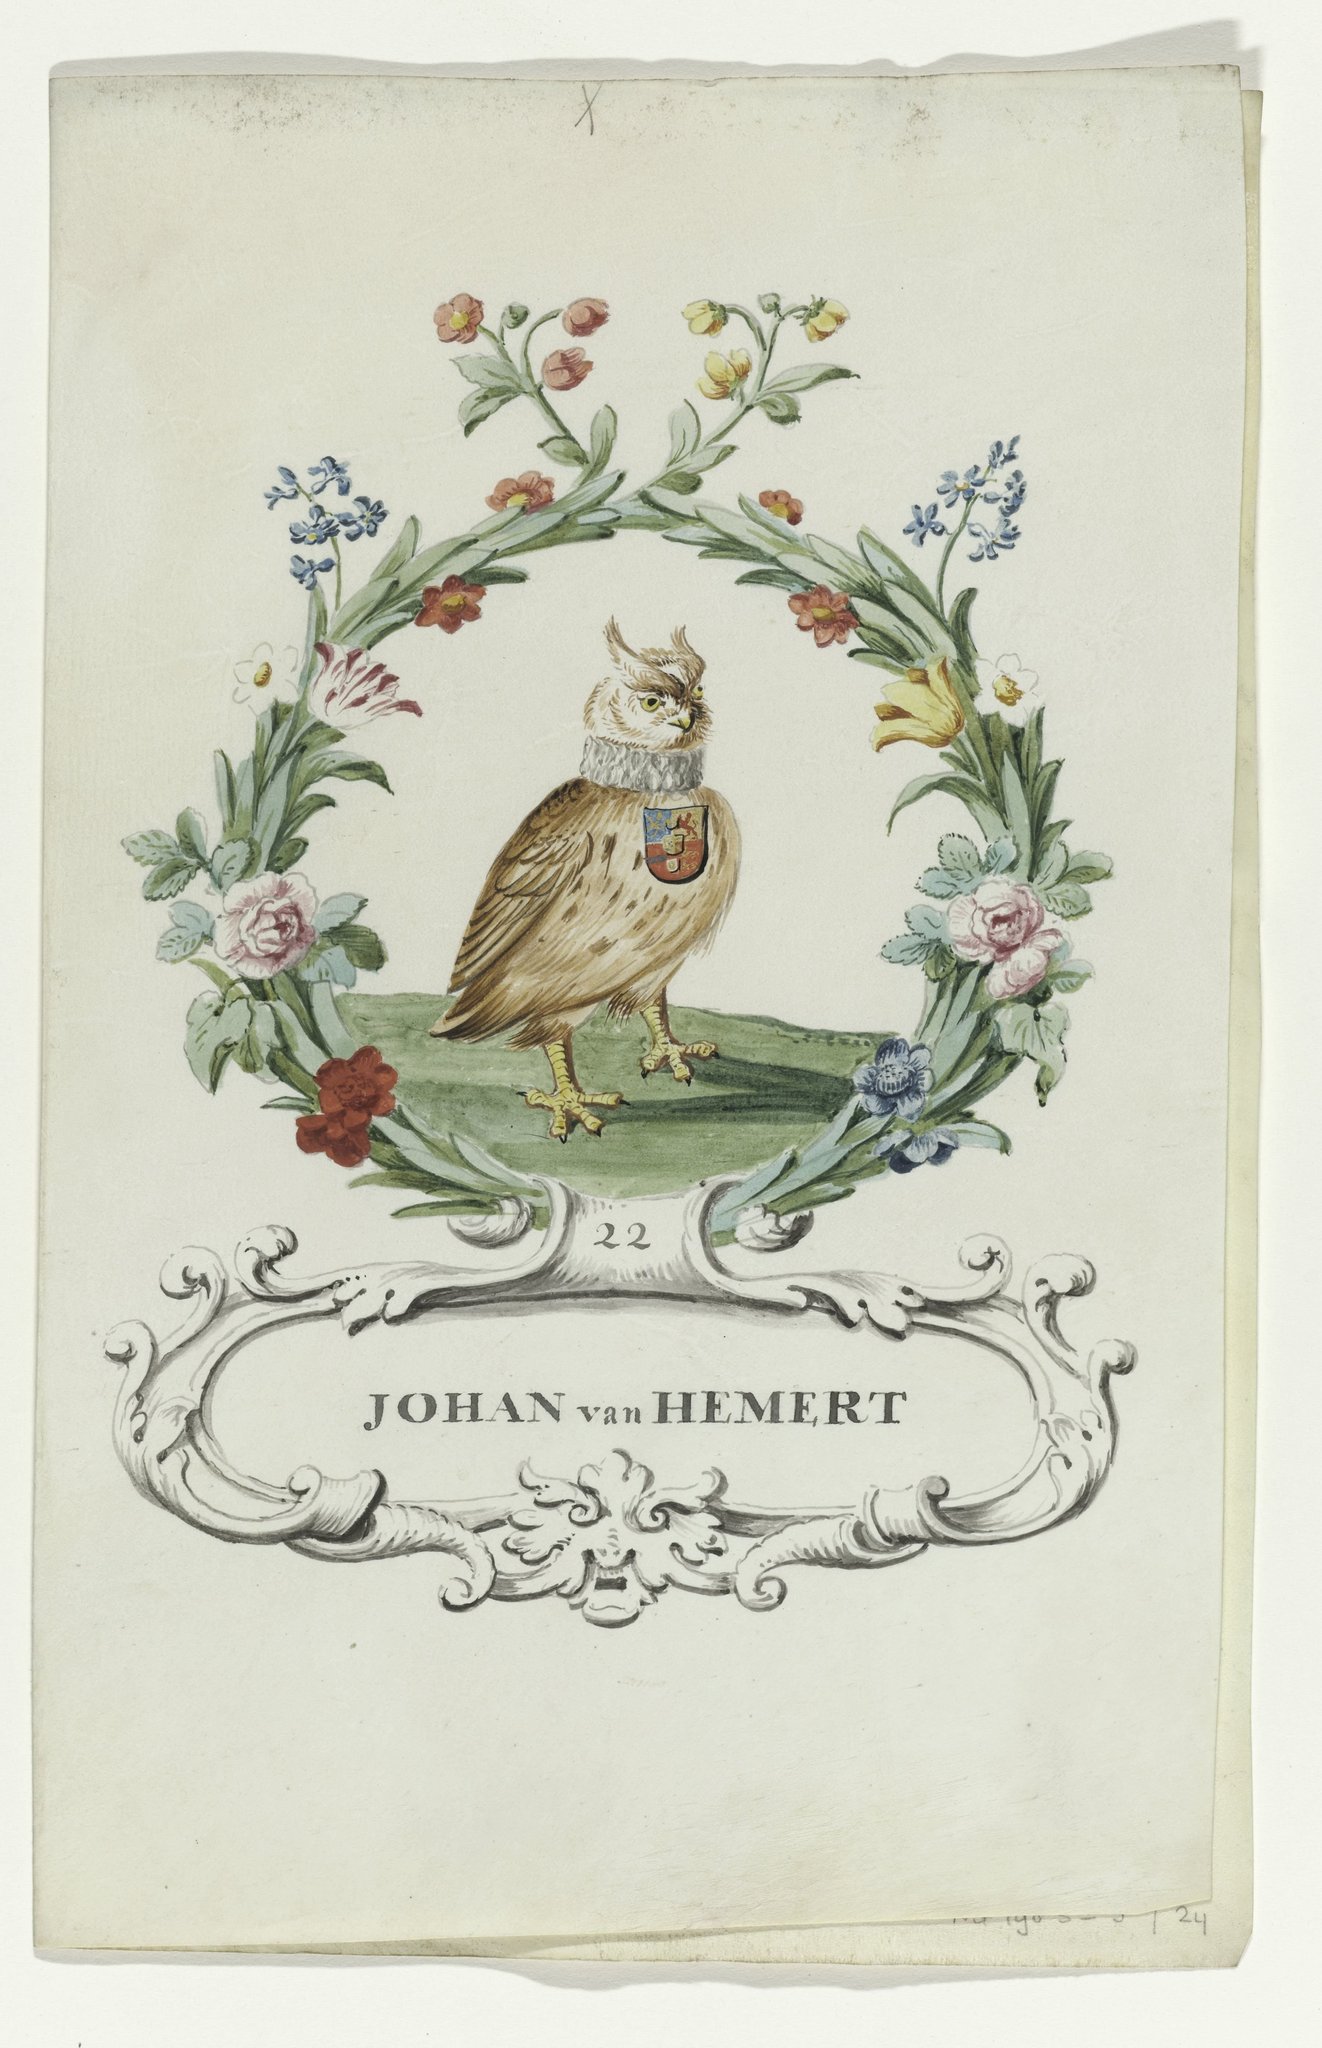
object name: drawing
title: Regtspleging van Oldenbarnevelt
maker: Anonymous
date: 1710-1720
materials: ink, parchment, watercolor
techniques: brush, pen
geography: netherlands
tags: the hague, johan van oldenbarnevelt, caricatures (human types), bad, corrupt judge, owls, political caricatures and satires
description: Spotprent van Johan van Hemert, rechter van Van Oldenbarnevelt; uil met plooikraag om en op de borst een wapen, in krans van bloemen en bladeren. Daaronder cartouche waarin naam en daarboven nr. 22. Behorende bij serie aquarellen in boek.